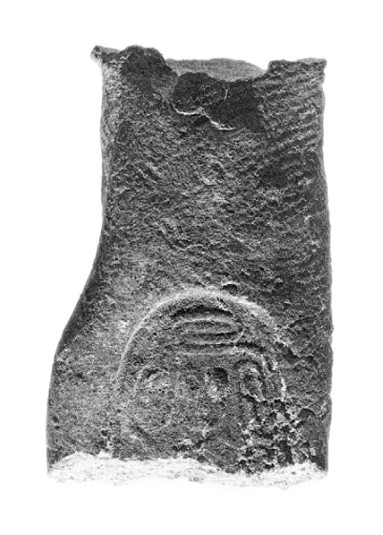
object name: sealing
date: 1981-1640 BCE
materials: mud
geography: egypt